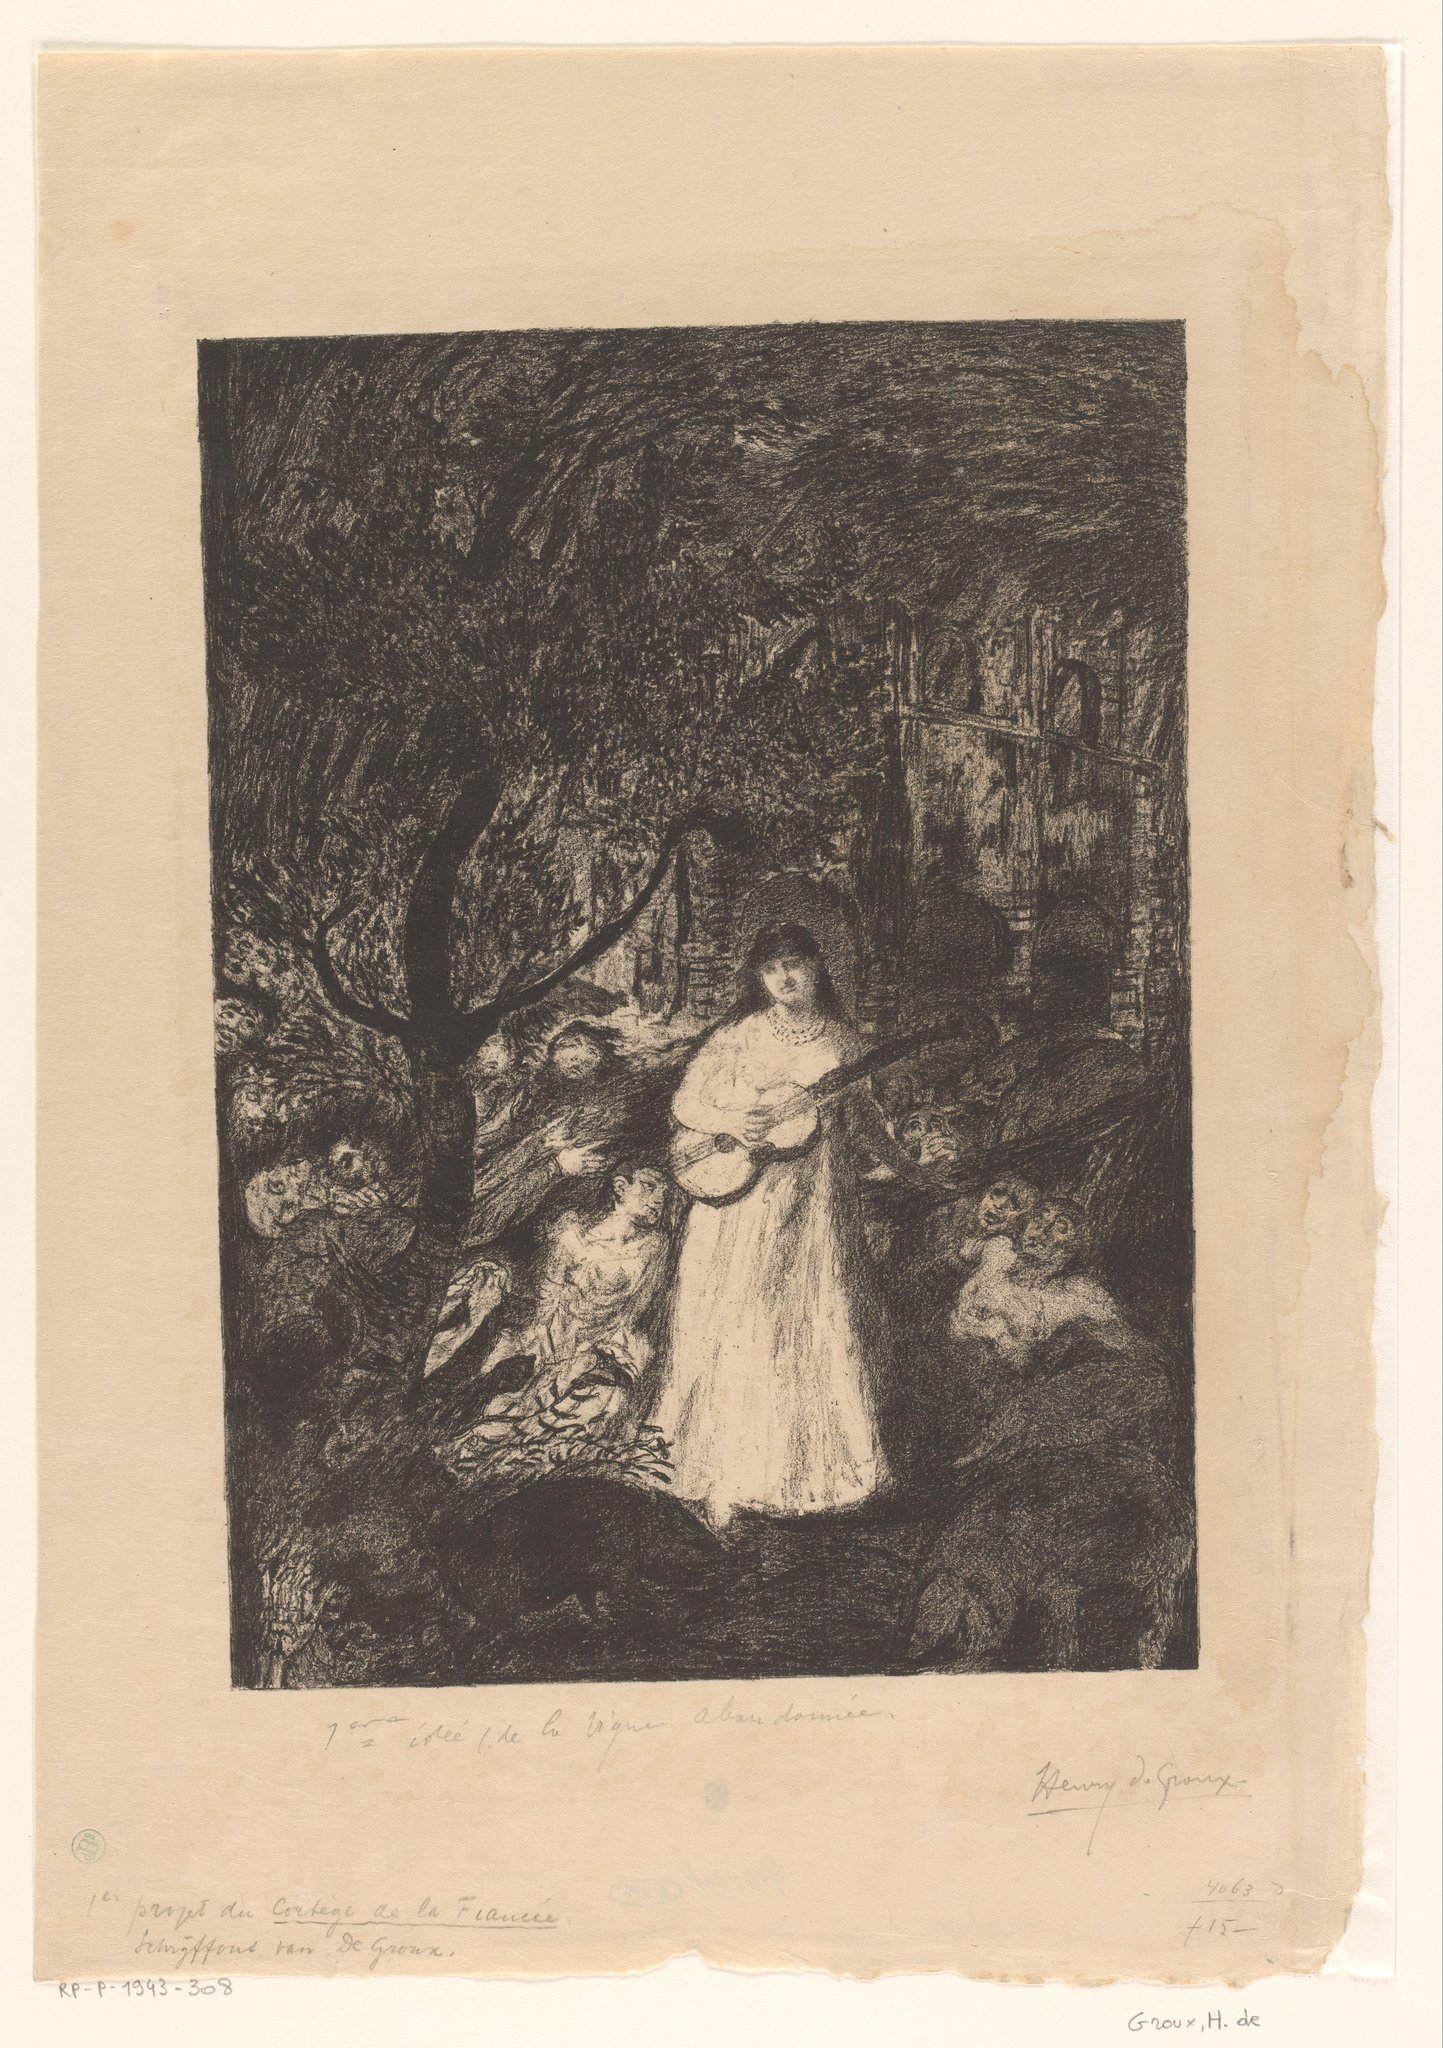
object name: print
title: Vrouw met gitaar in een bos met figuren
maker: henri de groux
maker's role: painter, print maker, sculptor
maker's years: 1866-1930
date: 1877-1894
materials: paper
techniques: lithograph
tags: adult woman, forest, wood, cithern, mandolin, guitar, balalaika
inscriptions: collector's mark: Lugt 2228, inscription: ‘1ere [estee] de la [vigue aban dormée]; 1er projet du cortège de la fiancée [...] van De Groux’, collector's mark: Lugt 2760, collector's mark: Lugt 733